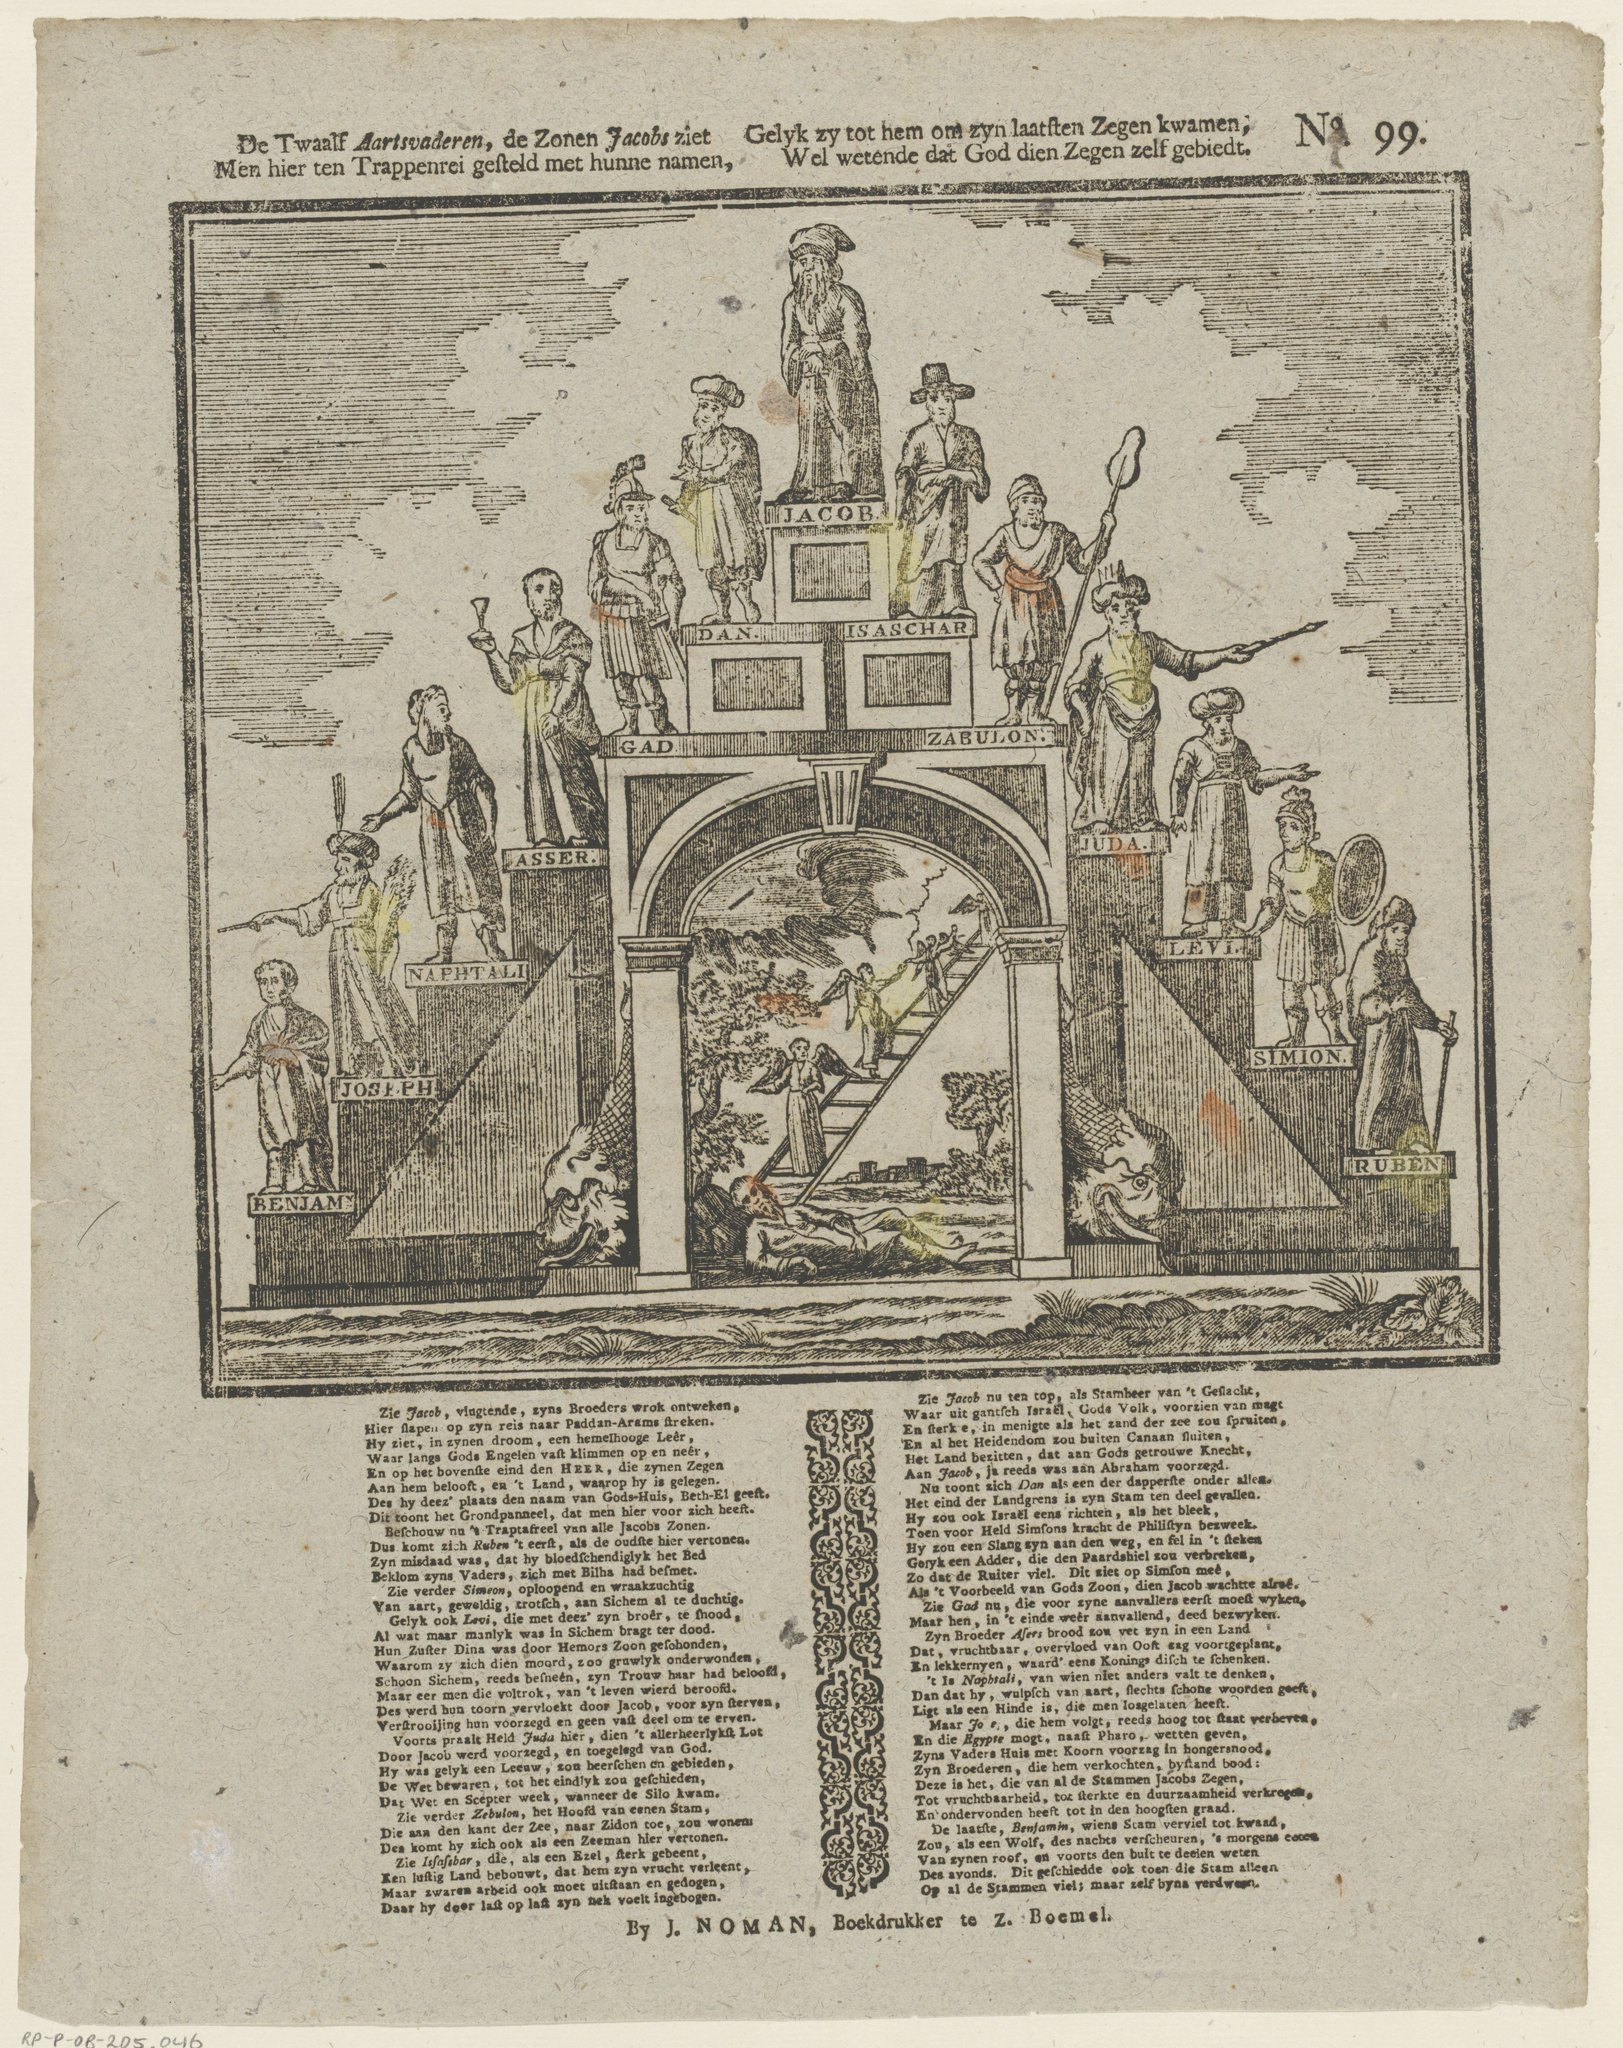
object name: print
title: De twaalf aartsvaderen, de zonen Jacobs ziet / Men hier ten trappenrei gesteld met hunnen namen, / Gelyk zy tot hem om zyn laatsten zegen kwamen, / Wel wetende dat God dien zegen zelf gebiedt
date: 1806-1830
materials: paper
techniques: colour, letterpress printing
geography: netherlands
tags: the twelve tribes of israel (not in biblical context), male persons from the old testament (with name) (not in biblical context), the dream of jacob: while sleeping on the ground with a stone for pillow jacob sees a ladder reaching from earth to heaven with angels going up and down; usually with god at the top of the ladder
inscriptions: collector's mark: Lugt 2760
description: Blad met een grote voorstelling van een trap met dertien treden. Op de treden staan Jacob en zijn twaalf zonen (aartsvaderen). In de boog onder de trap Jacobs droom met de ladder. Onder de afbeelding een vers in twee kolommen. Genummerd rechtsboven: No. 99.